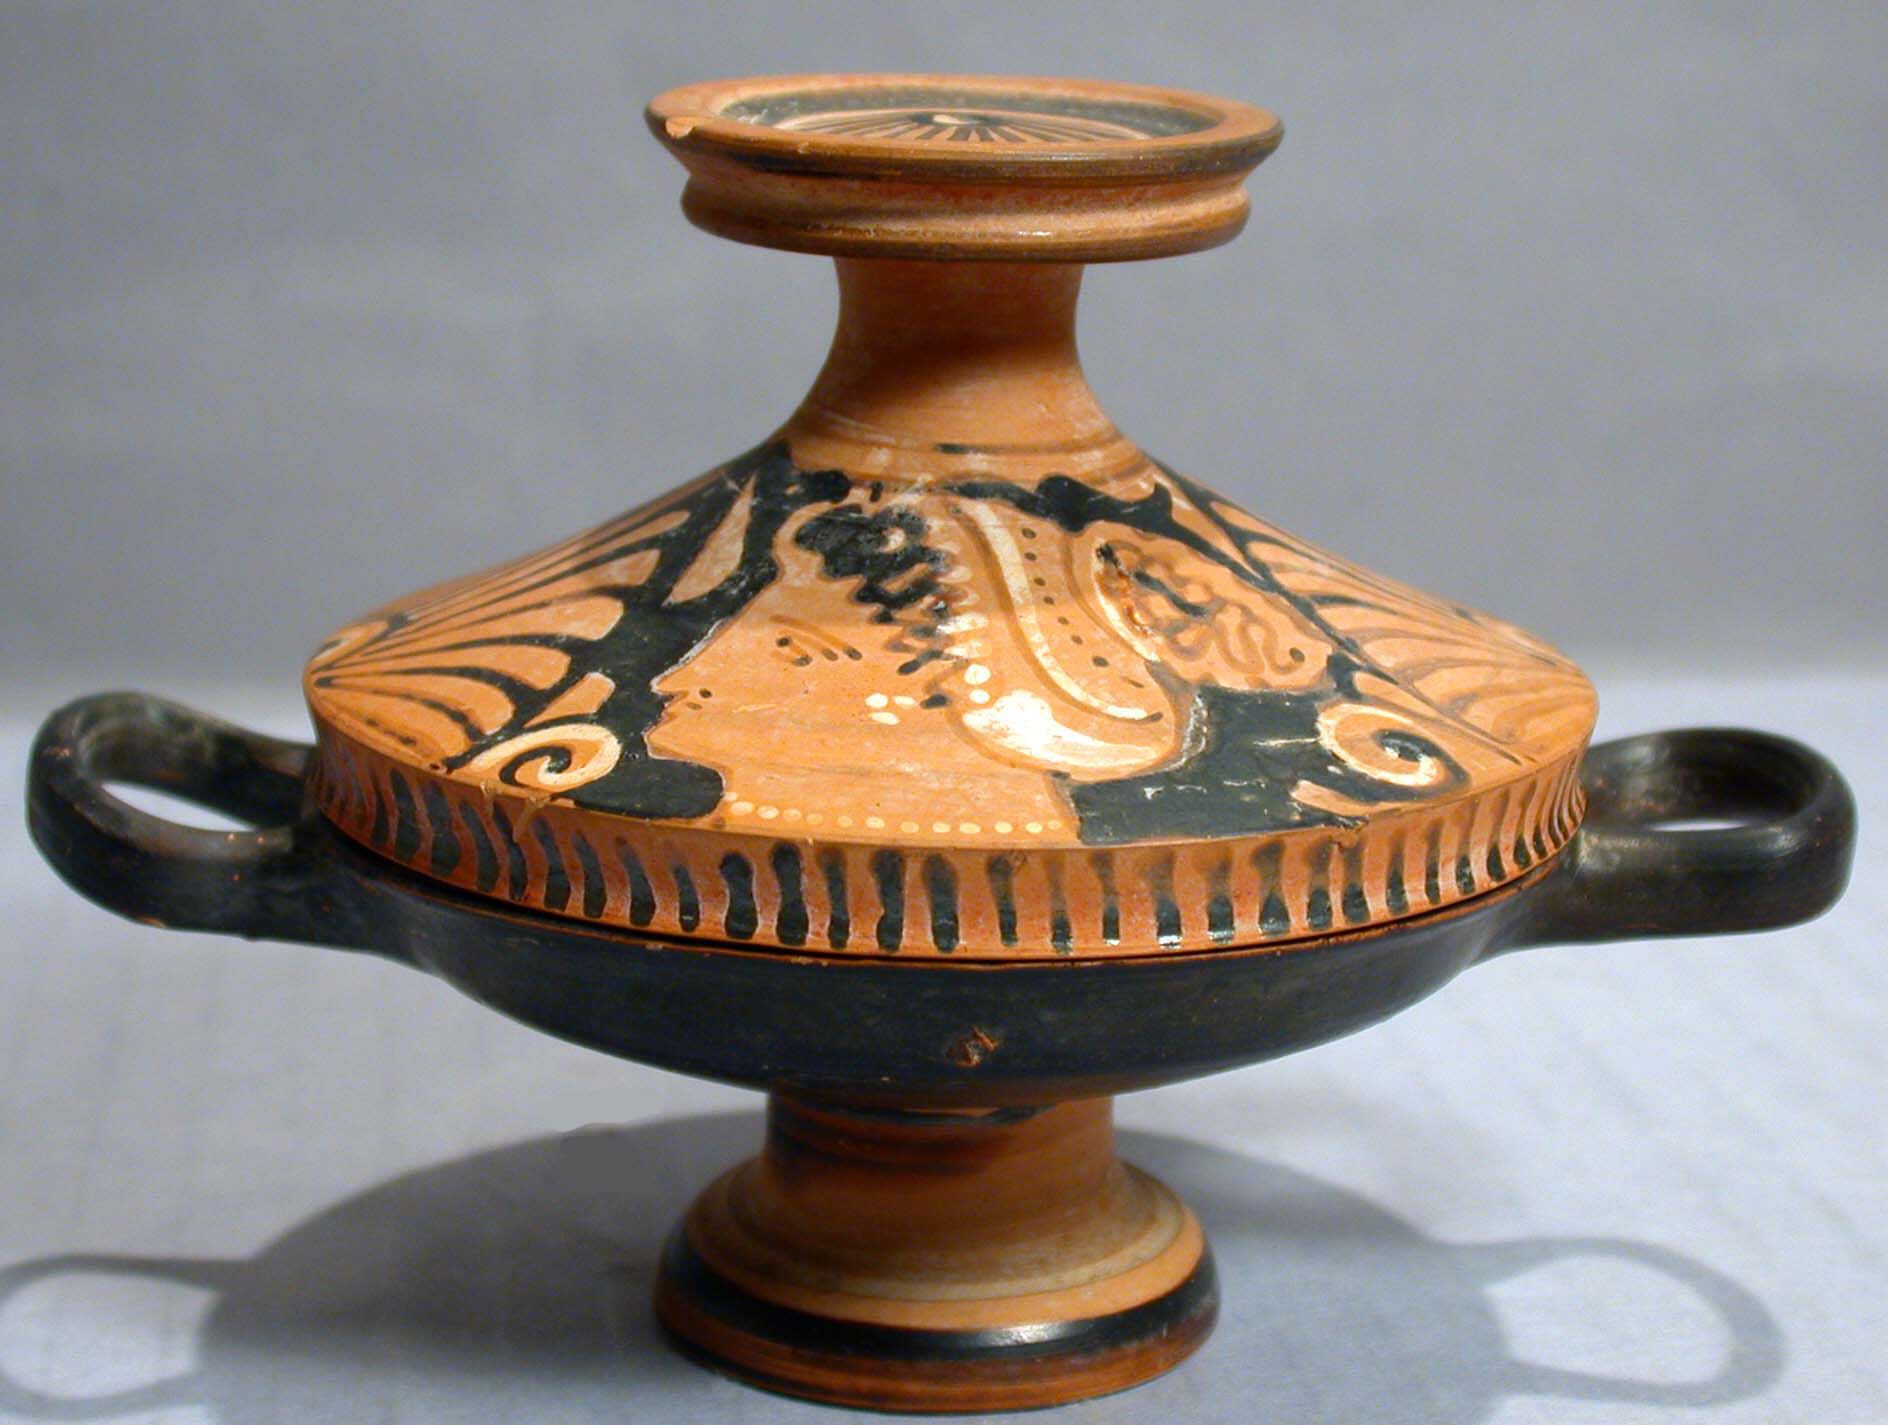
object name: lekanis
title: Terracotta lekanis (dish) with lid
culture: greek, south italian, apulian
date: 350-301 BCE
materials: terracotta